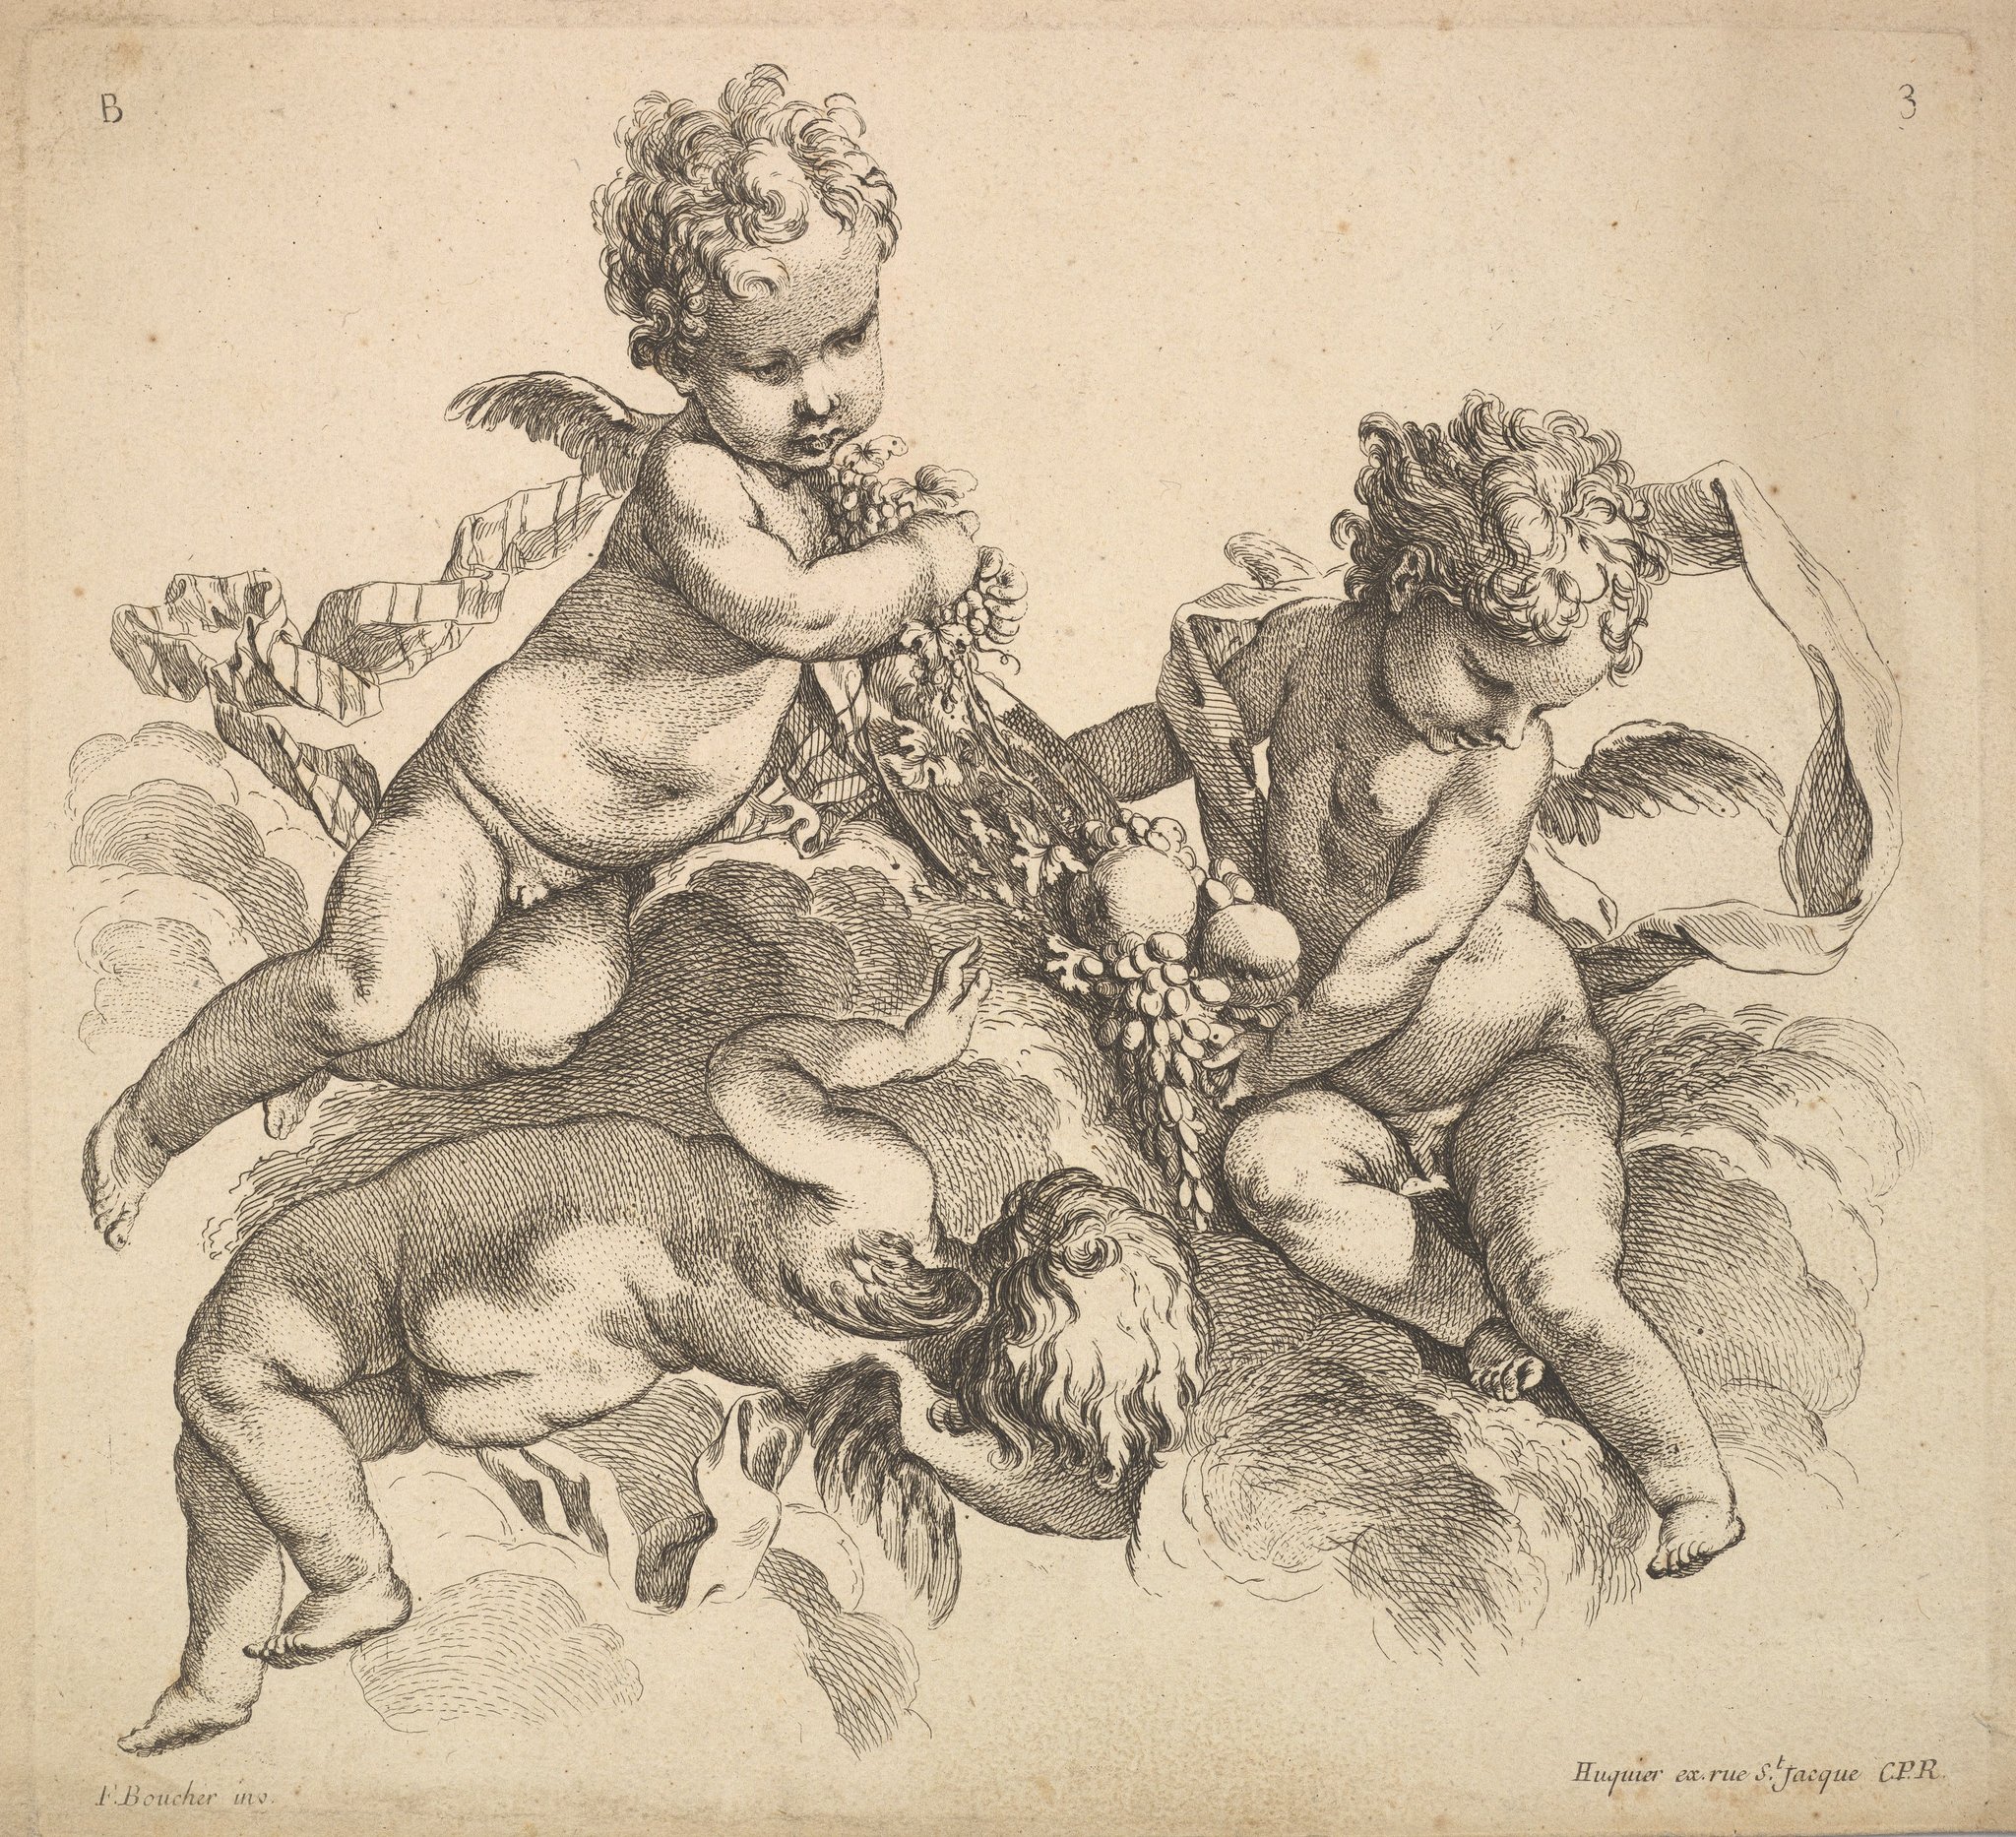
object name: print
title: Three Children with a Fruit Plate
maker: gabriel huquier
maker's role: artist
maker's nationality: french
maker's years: 1695-1772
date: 1738-1745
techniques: engraving, etching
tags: fruit,infants